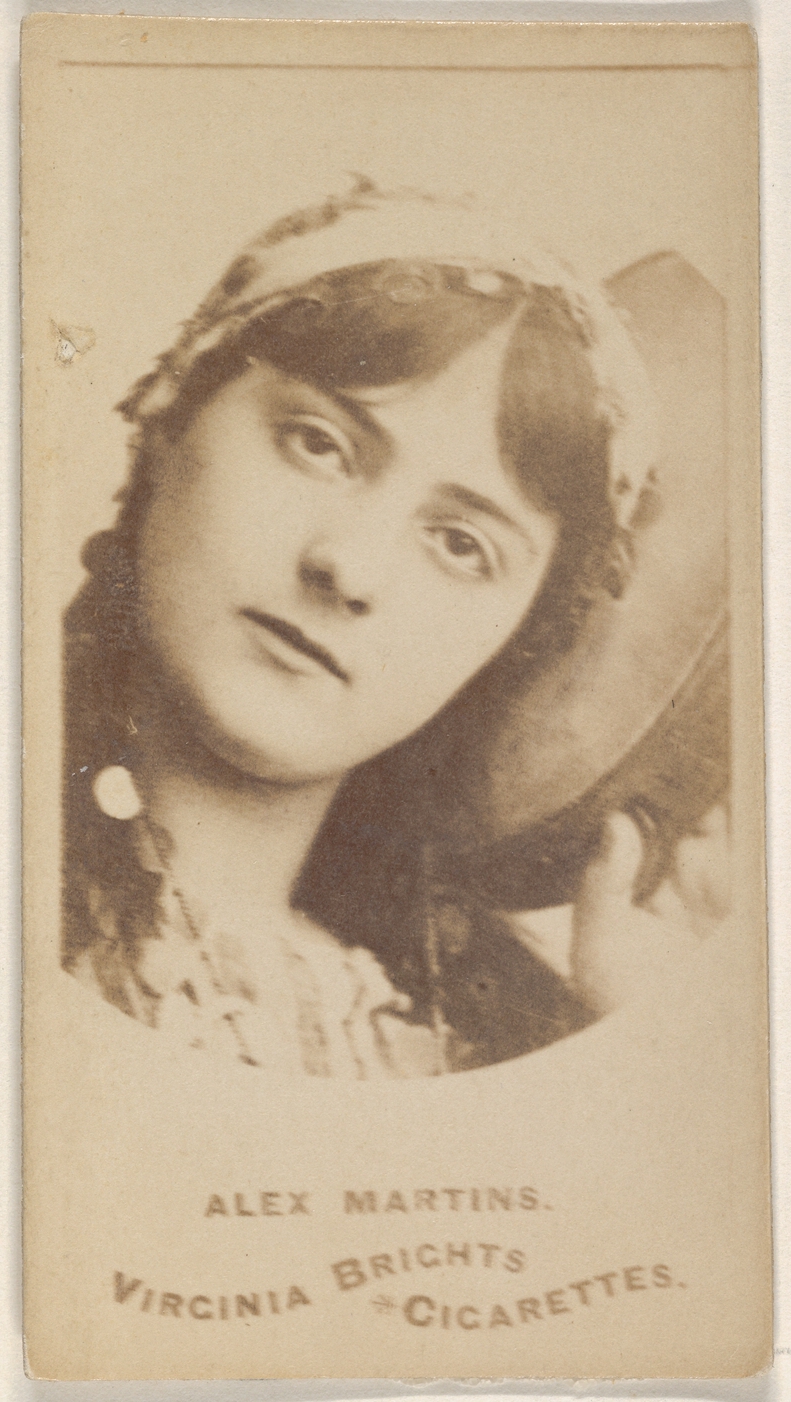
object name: photograph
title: Alex Martins, from the Actors and Actresses series (N45, Type 1) for Virginia Brights Cigarettes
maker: allen & ginter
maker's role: publisher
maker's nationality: american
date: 1888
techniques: albumen silver print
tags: portraits,women,actresses